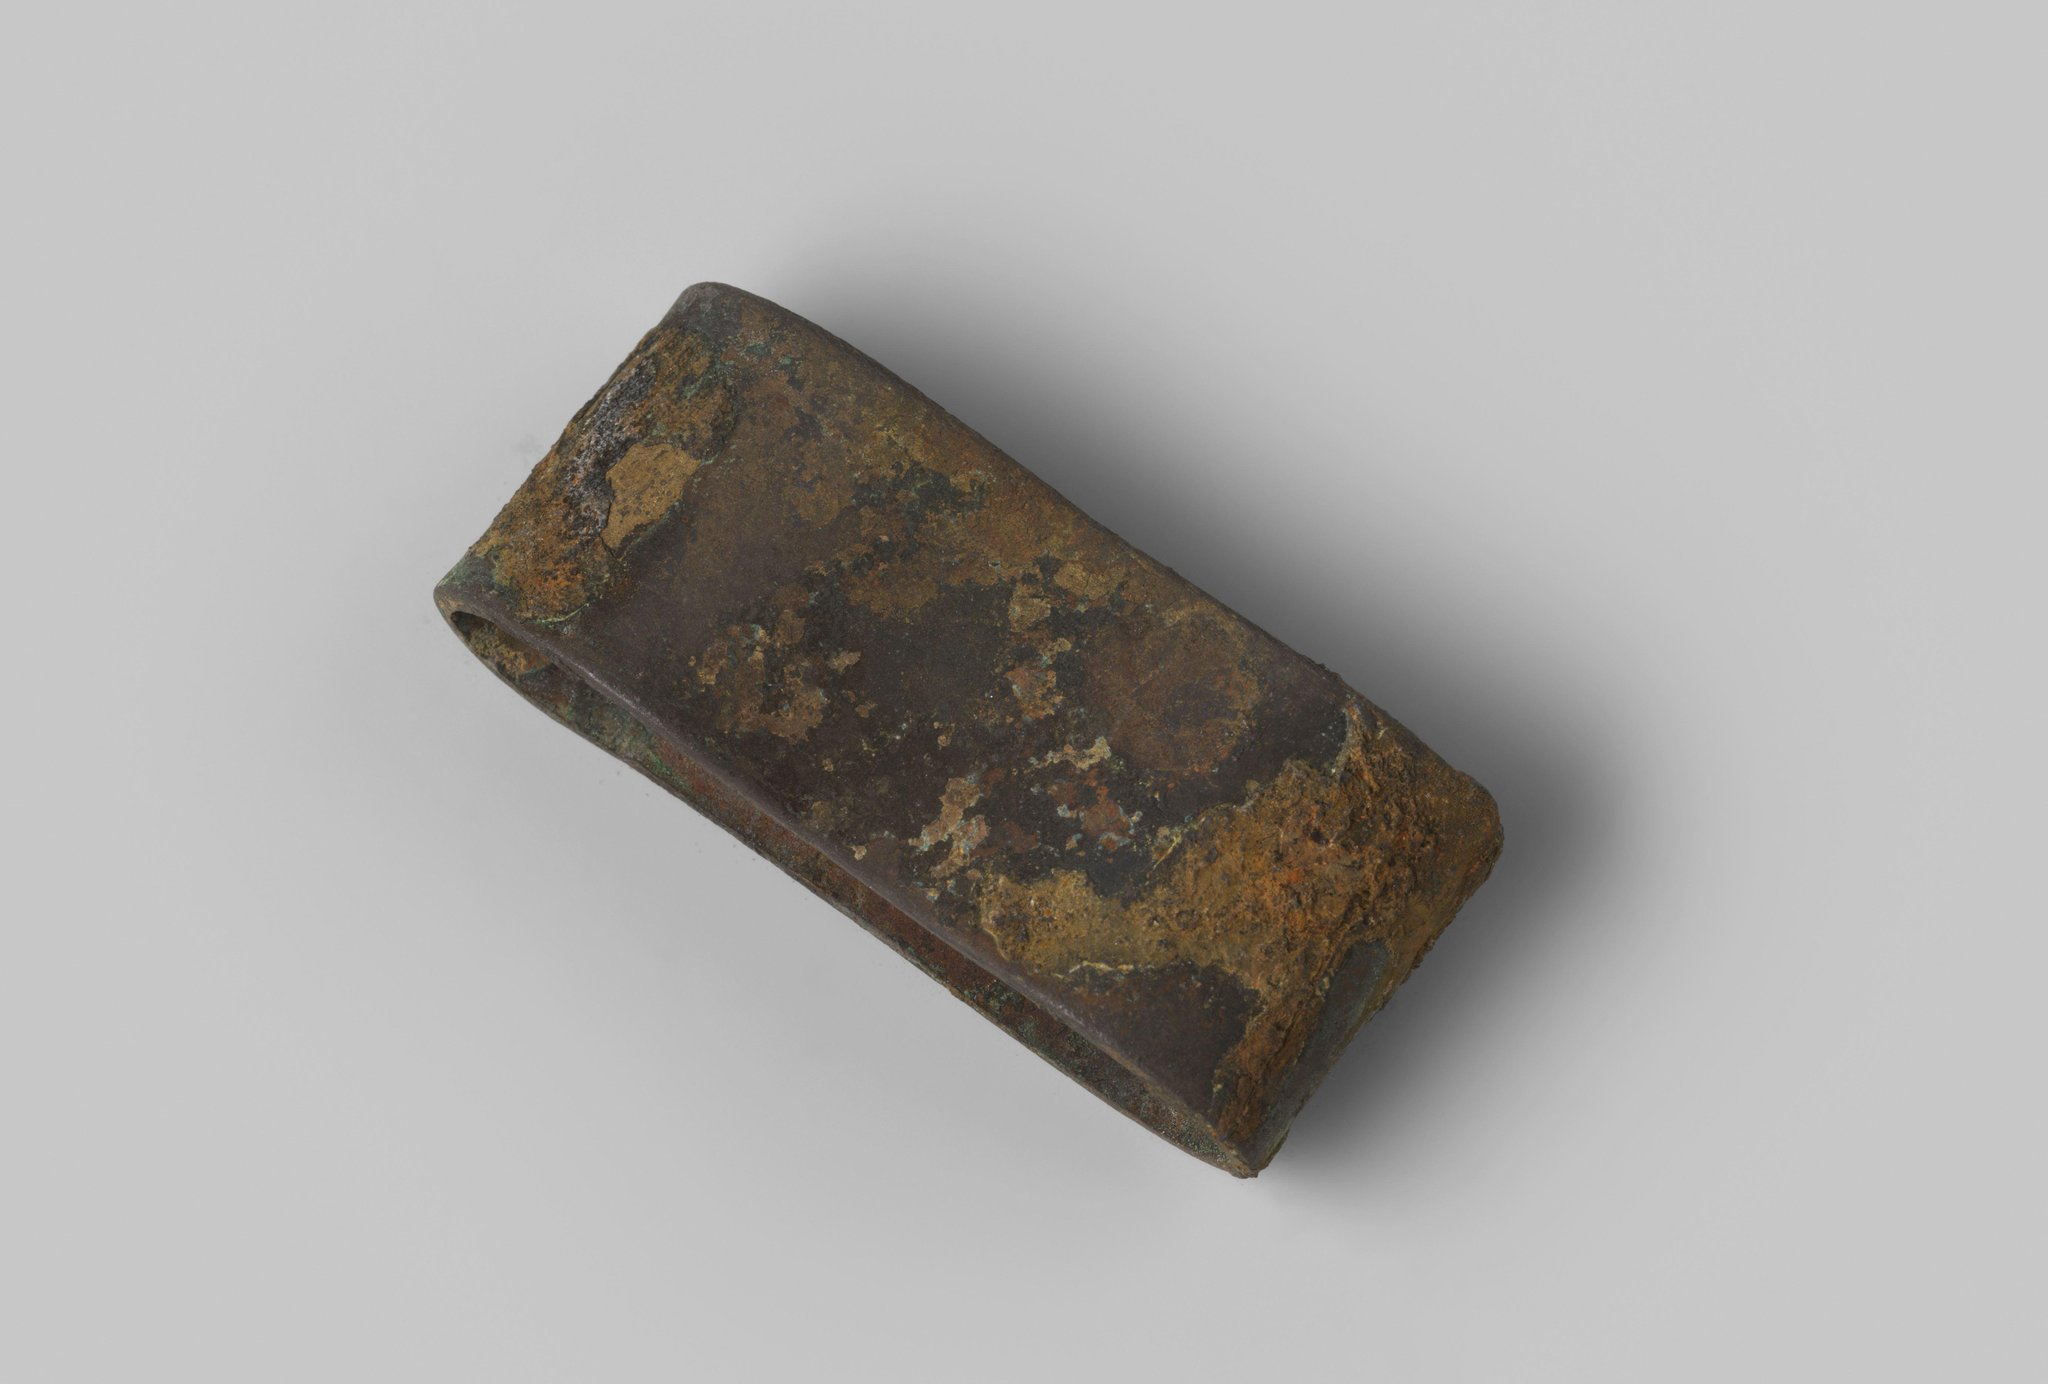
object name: firehose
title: Fragment van een brandslangring uit het wrak van de Oost-Indiëvaarder Hollandia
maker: Anonymous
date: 1700-1743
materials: copper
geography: netherlands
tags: verenigde oostindische compagnie, hollandia (schip), annet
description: Fire engine, firehose; fragment, id. NG-1975-20-H-1271-a, squashed.